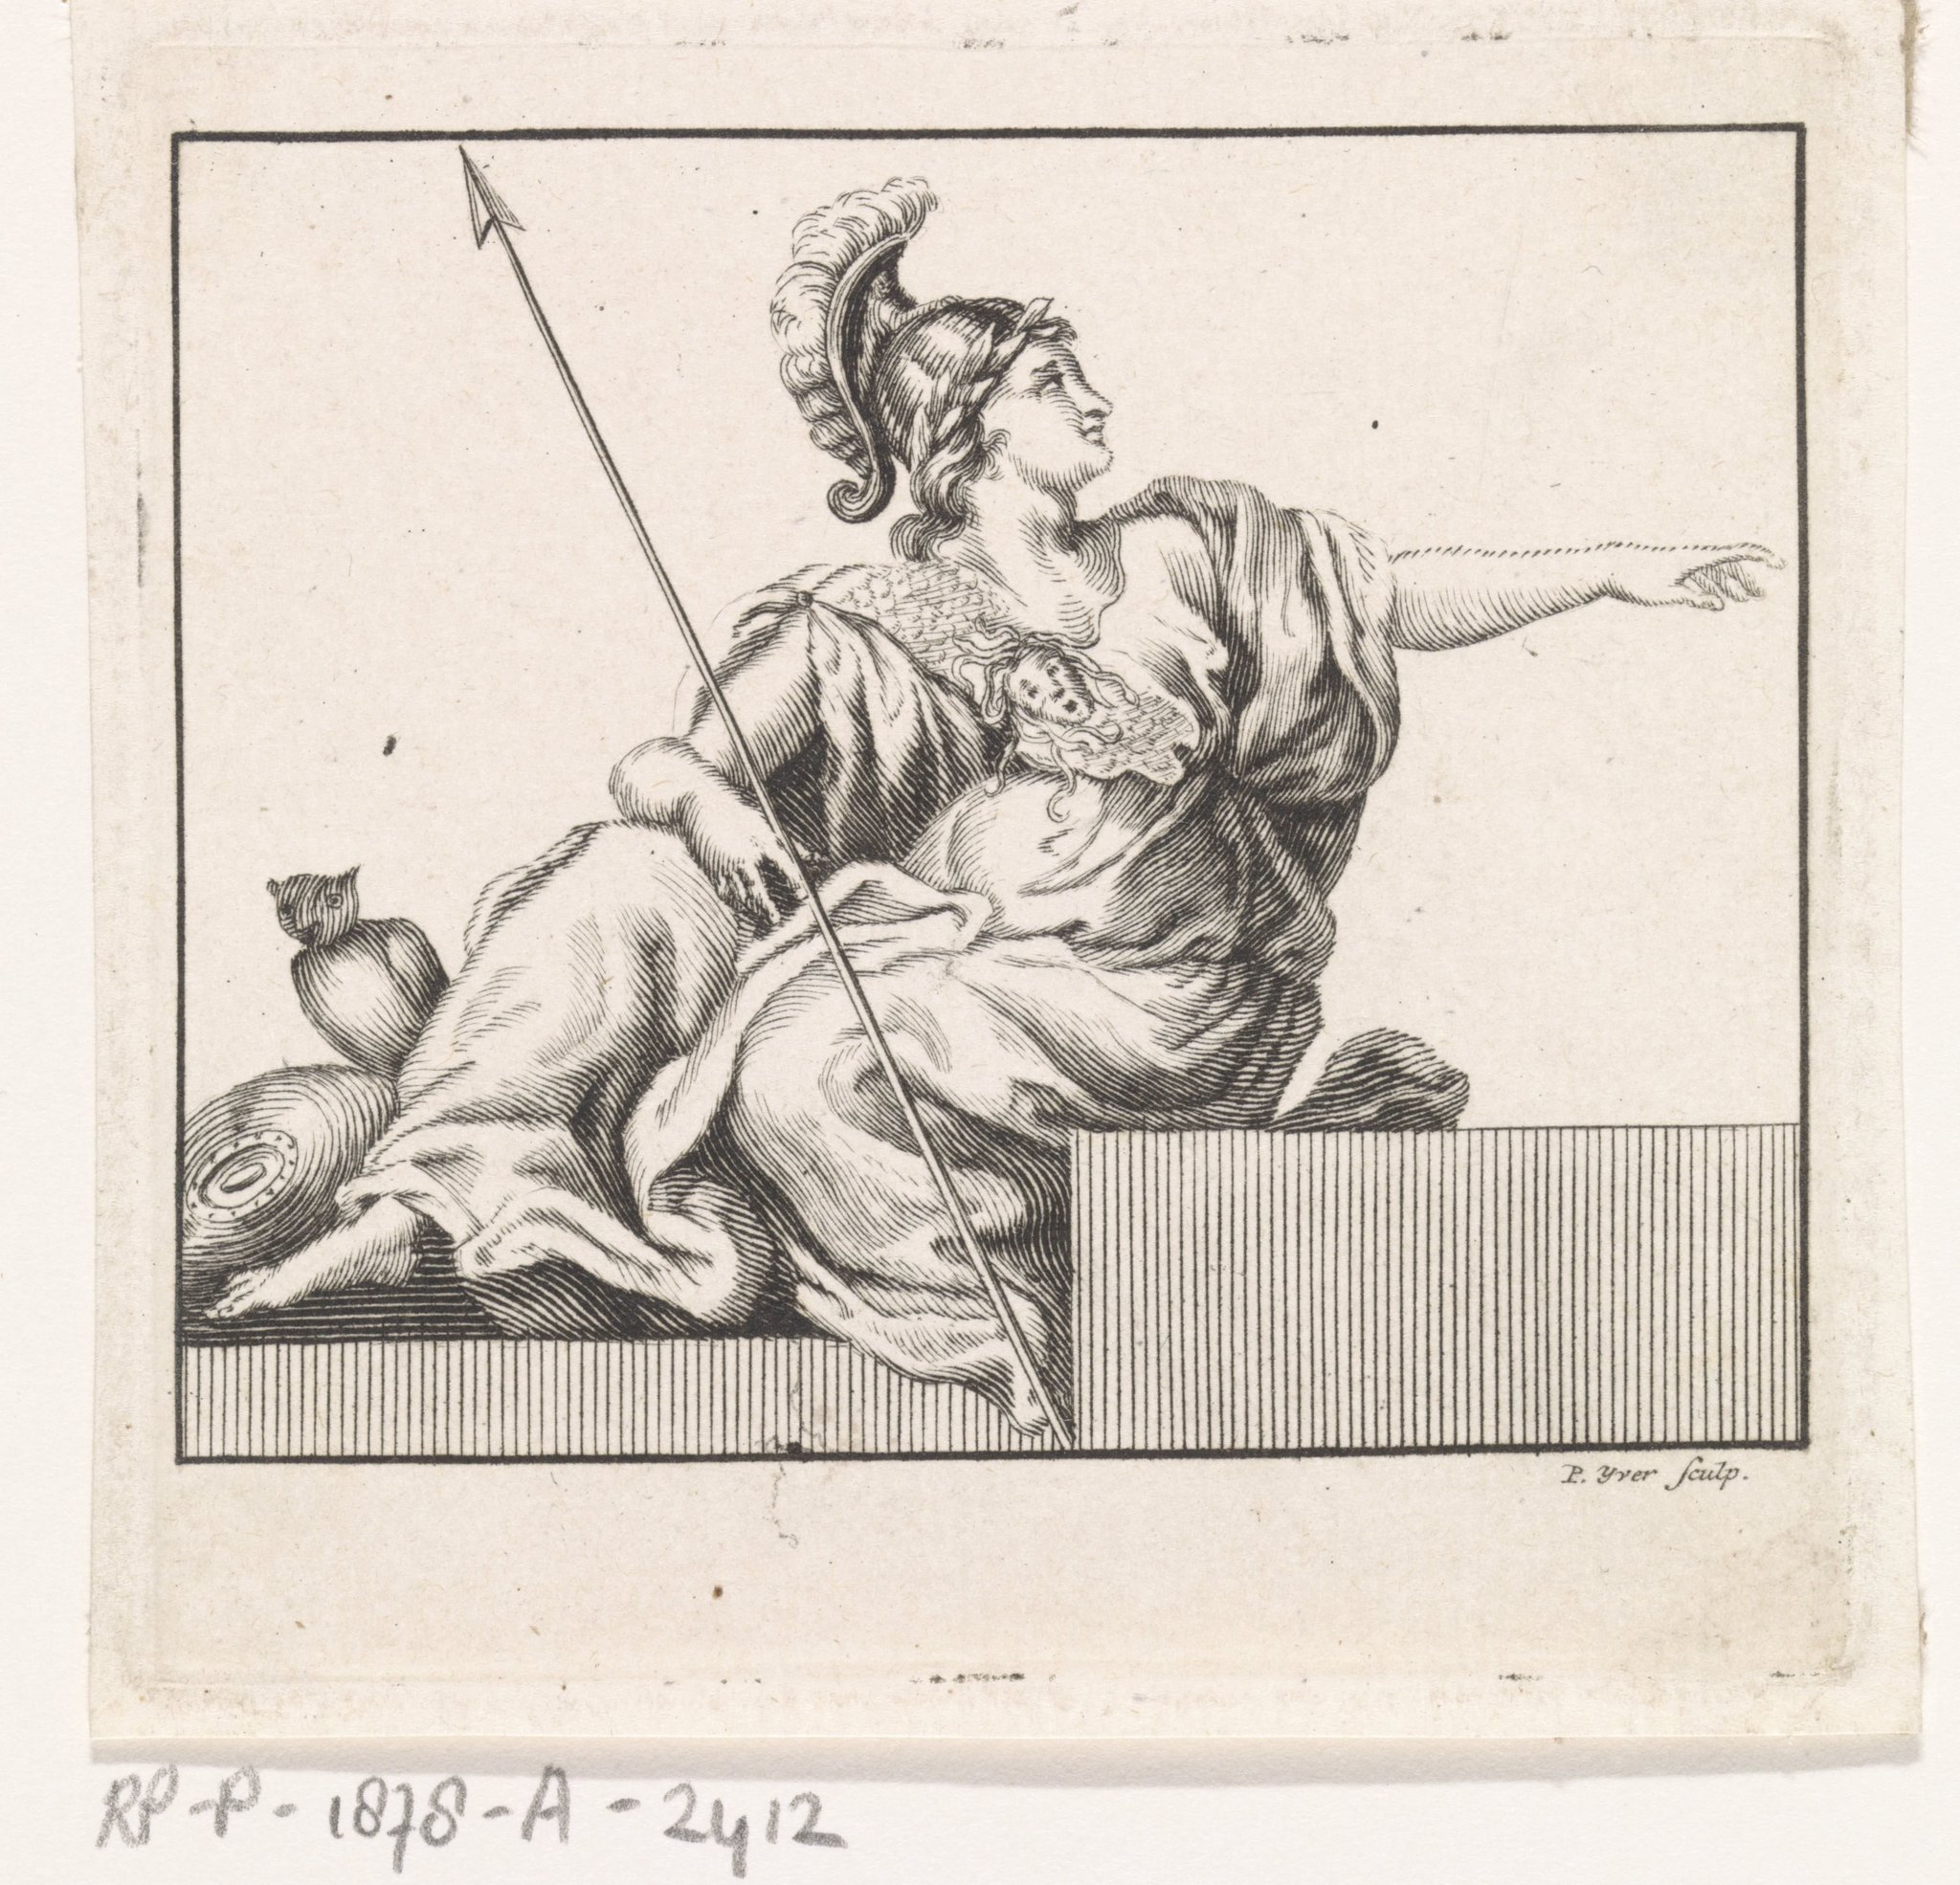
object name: print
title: Minerva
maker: pieter yver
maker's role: print maker, publisher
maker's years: 1712-1787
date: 1722-1787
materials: paper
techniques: etching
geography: amsterdam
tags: (story of) minerva (pallas, athena), attributes of minerva: owl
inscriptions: collector's mark: Lugt 2228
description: Minerva met haar speer in de hand en het schild en de uil naast zich.